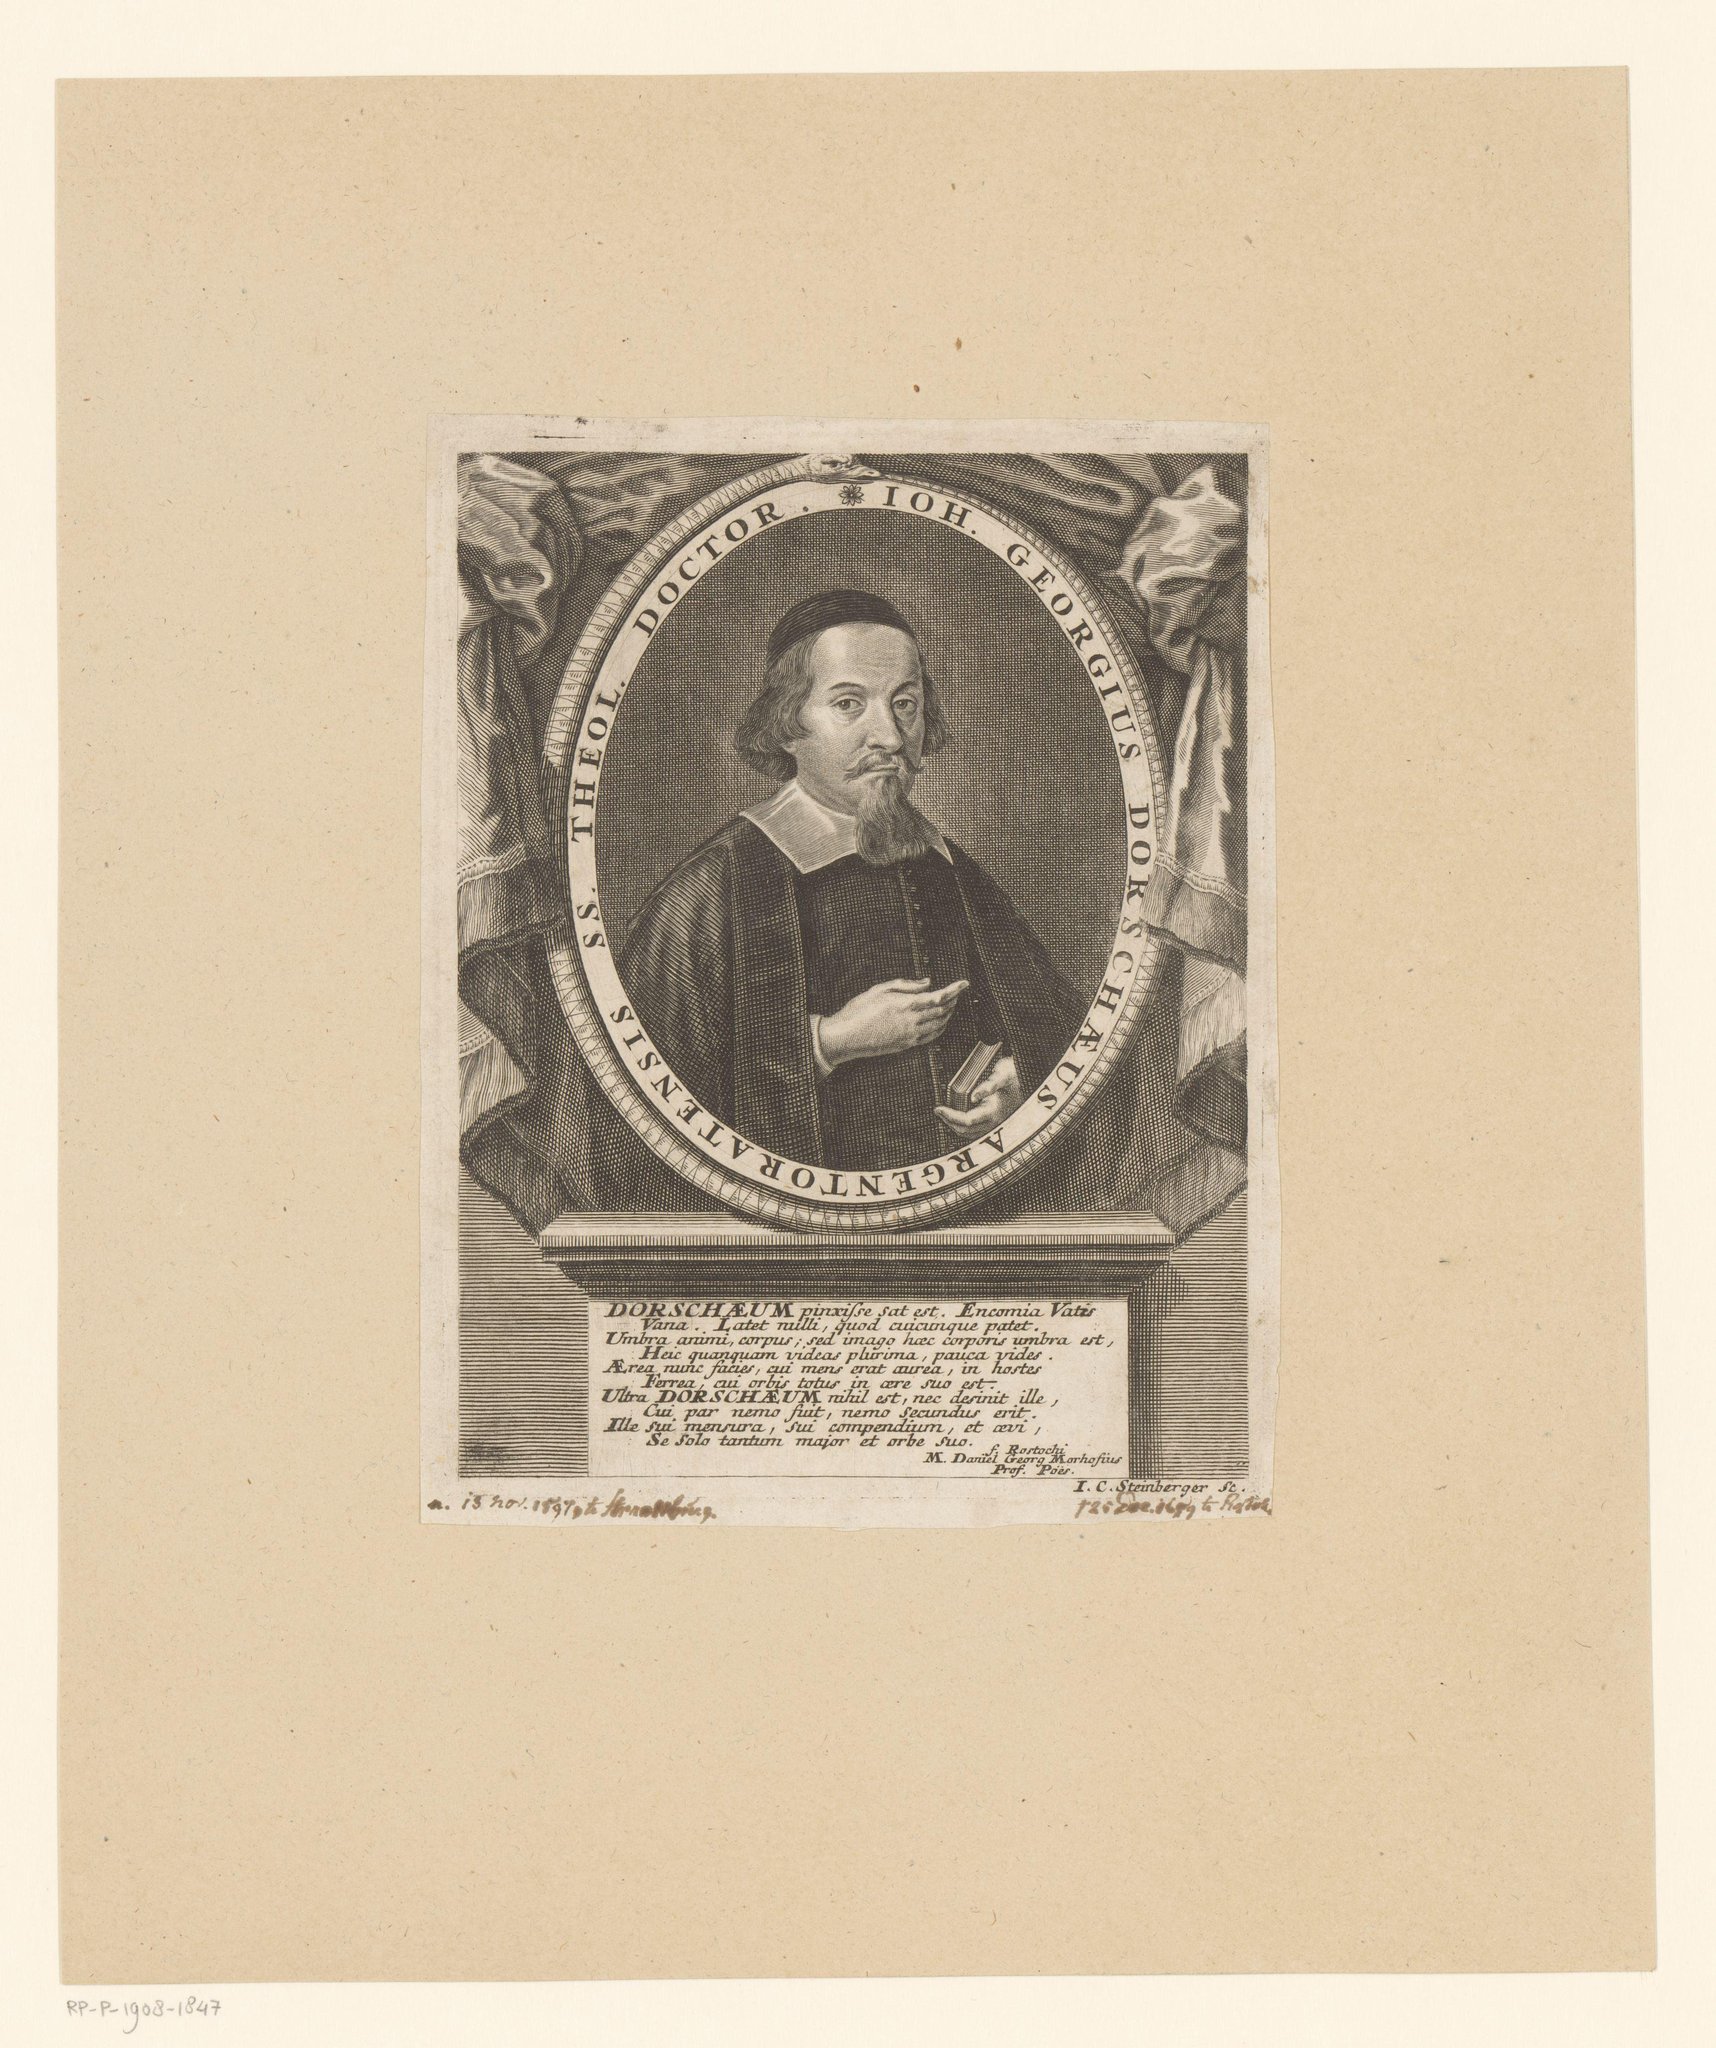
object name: print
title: Portret van Johann Georg Dorsch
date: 1690-1727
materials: paper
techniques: engraving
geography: rostock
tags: johann georg dorsch, historical persons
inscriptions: collector's mark: Lugt 2228